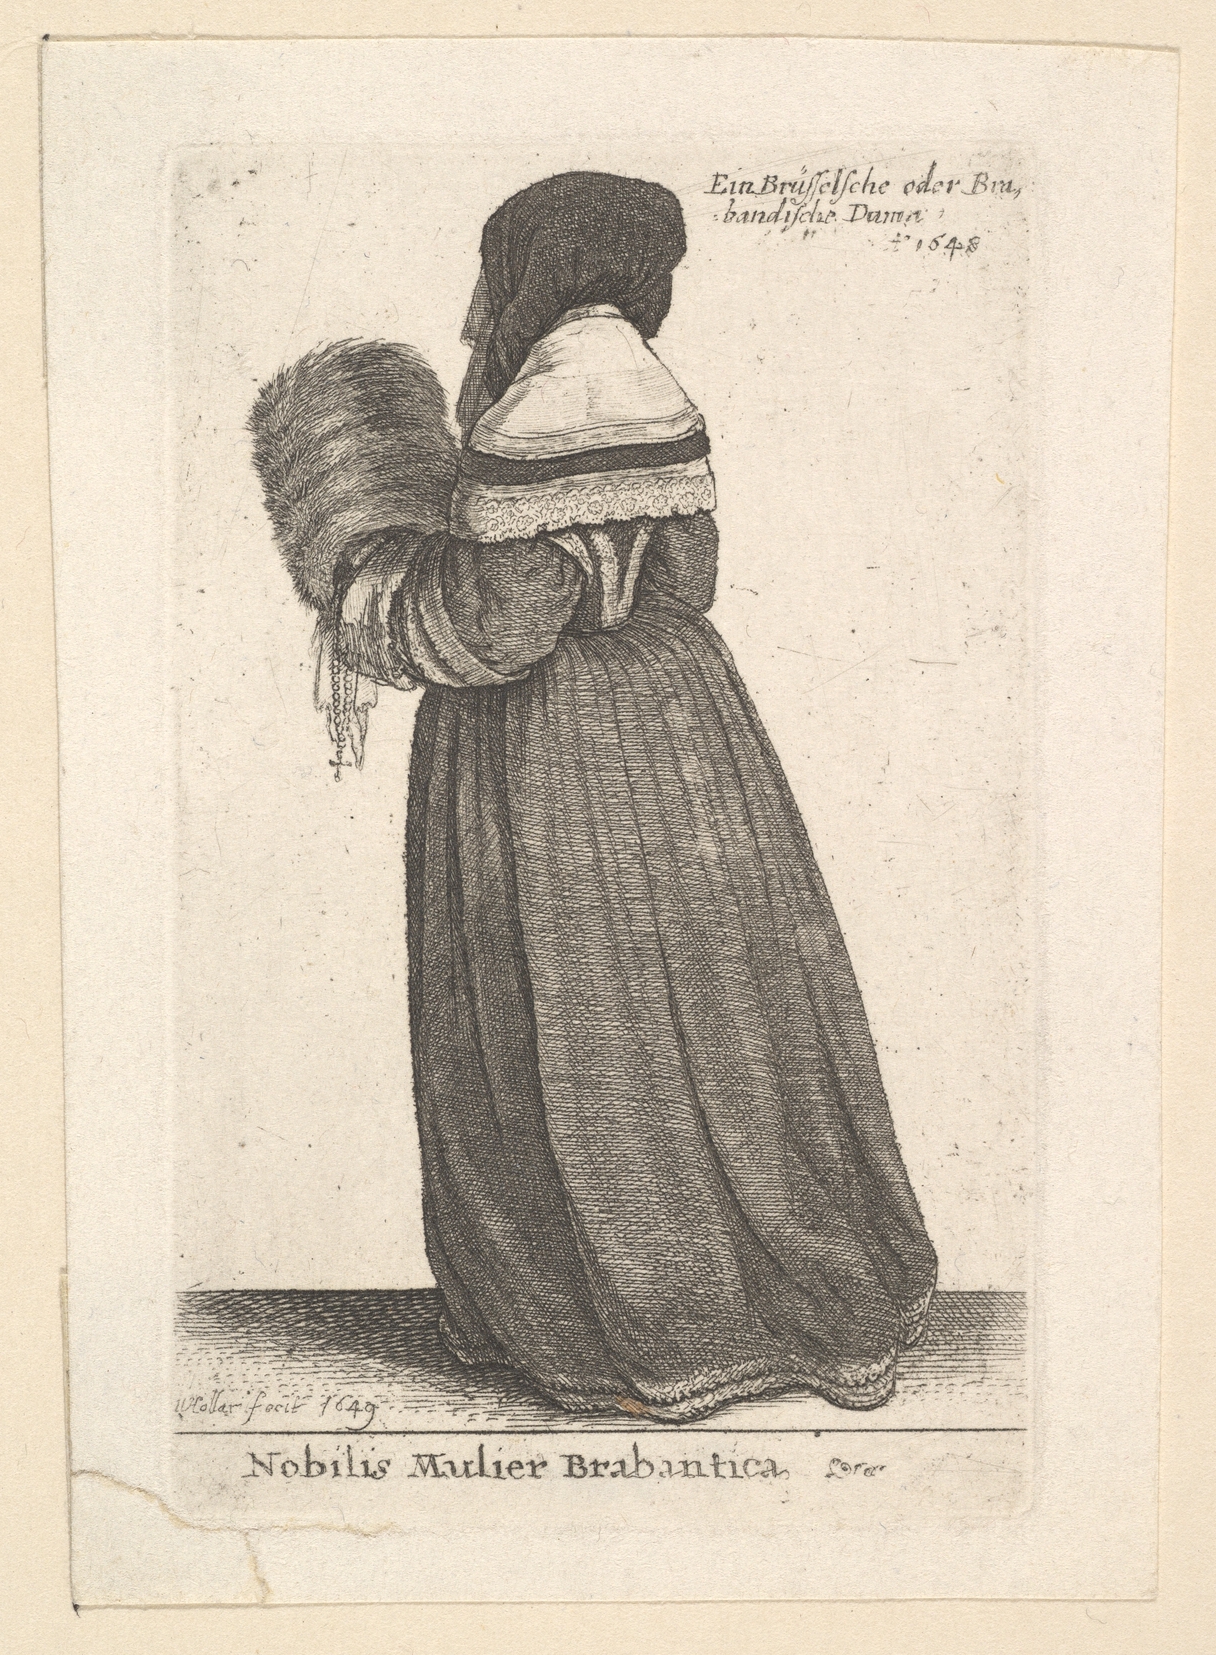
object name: print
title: Nobilis Mulier Brabantica, (Noblewoman from Brabant)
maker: wenceslaus hollar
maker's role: artist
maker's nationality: bohemian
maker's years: 1607-1677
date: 1649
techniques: etching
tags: women